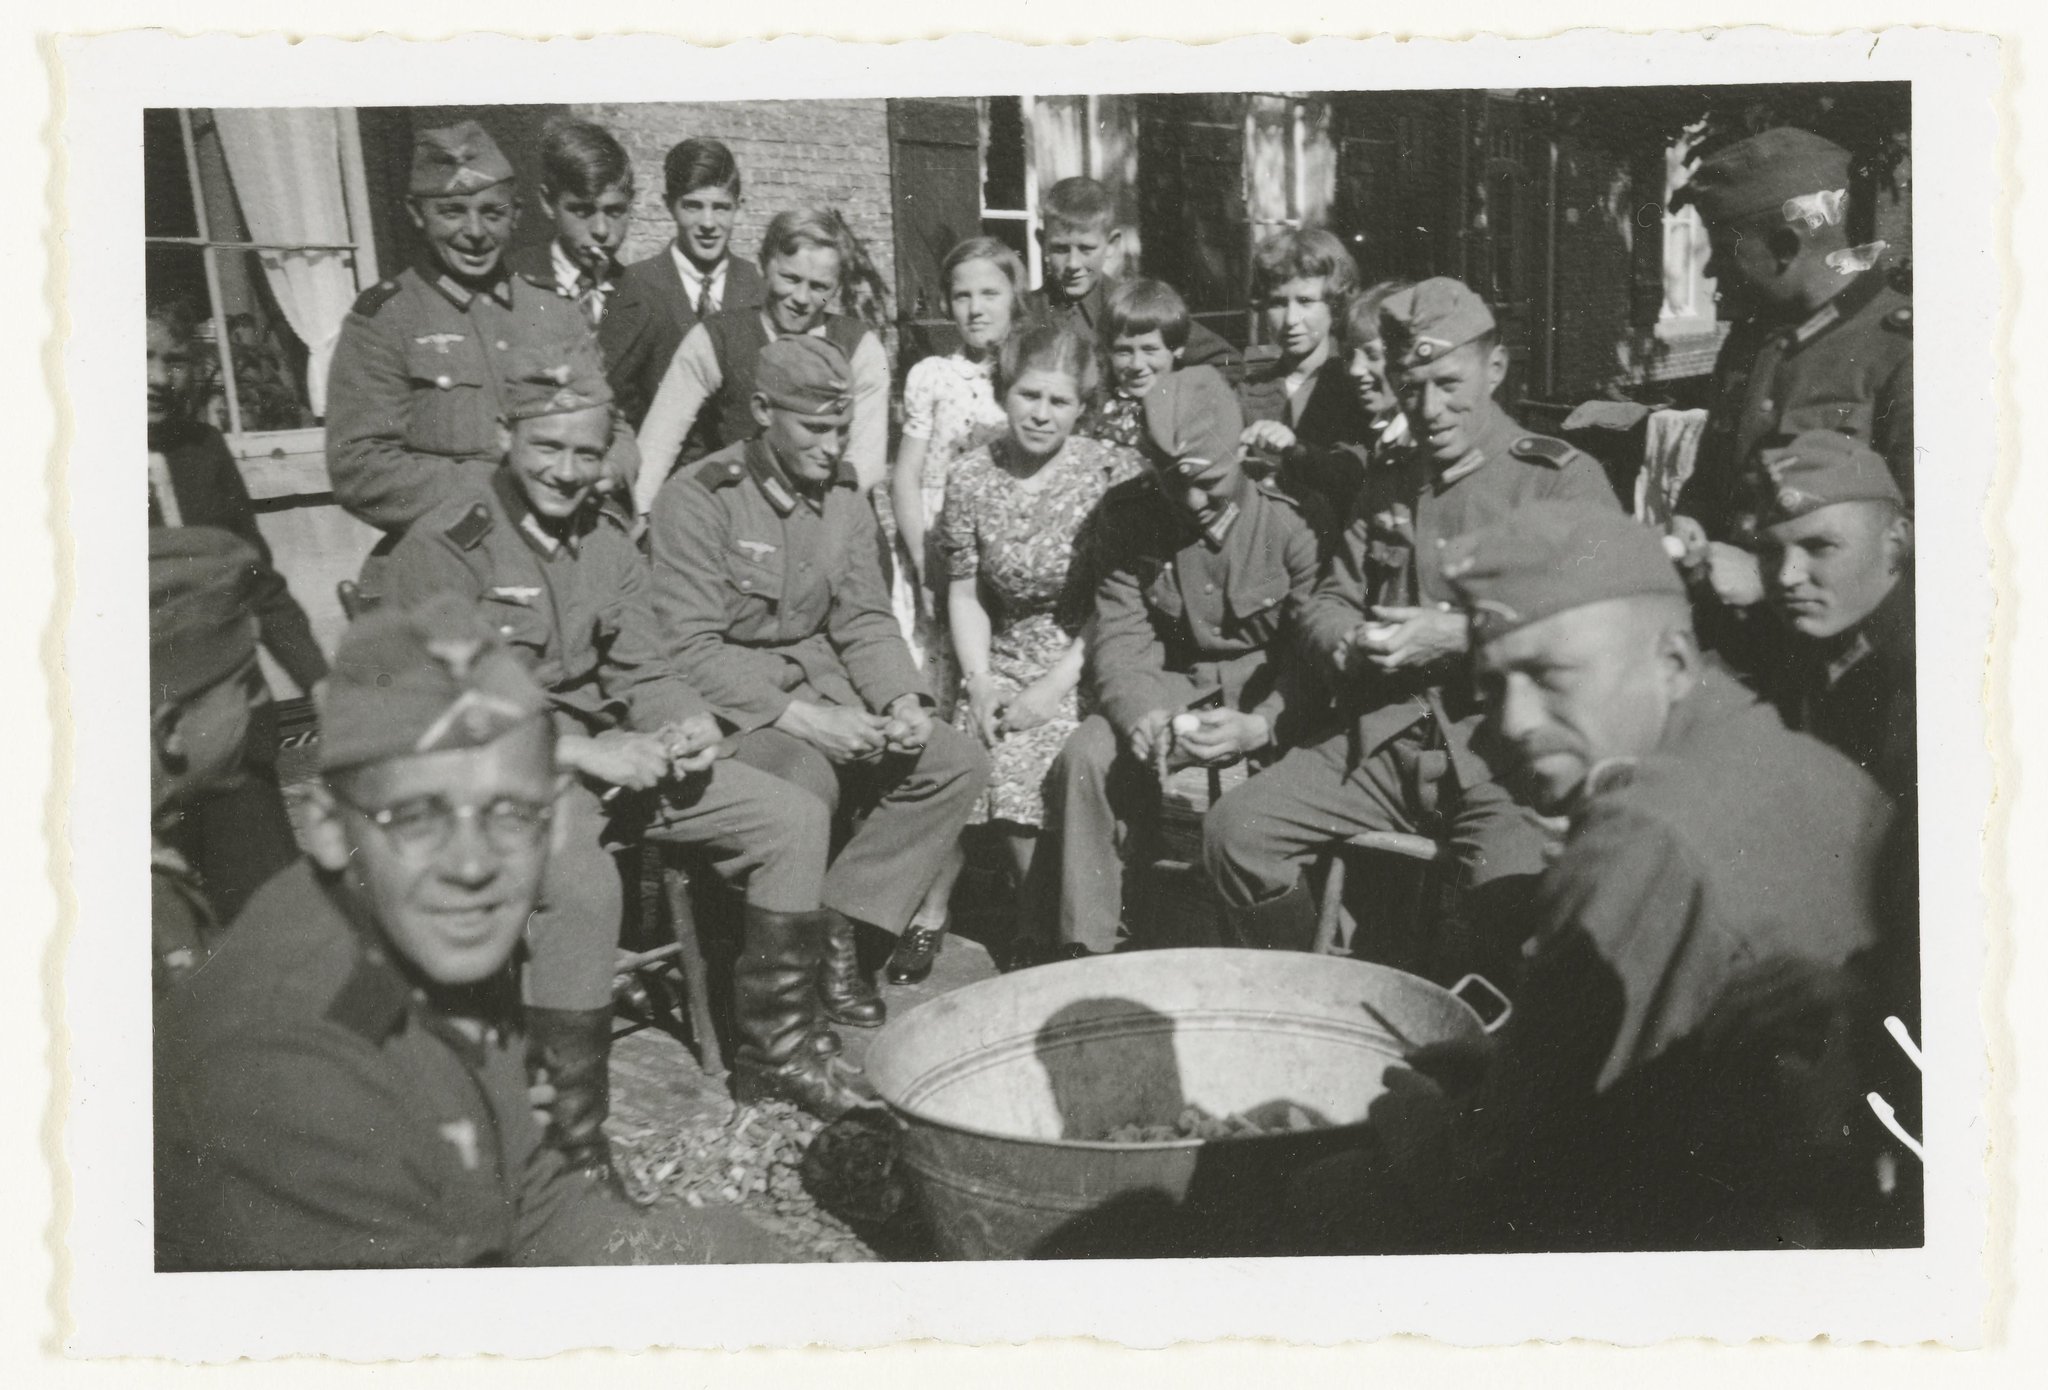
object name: photograph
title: Duitse soldaten schillen aardappelen.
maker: Anonymous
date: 1909-1940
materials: photographic support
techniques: gelatin silver print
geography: raamsdonksveer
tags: occupier and civilians, occupation ~ war, cleaning vegetables - cc - in the open air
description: Tien Duitse soldaten helpen met aardappelen schillen. De aardappelen gaan in een grote teil. Om hen heen staan tien Nederlandse kinderen. Het is mooi weer en het gaat er gemoedelijk aan toe. Op de achterzijde staat: Holland Sept. 1940. Adriane zwischen den II Zug.